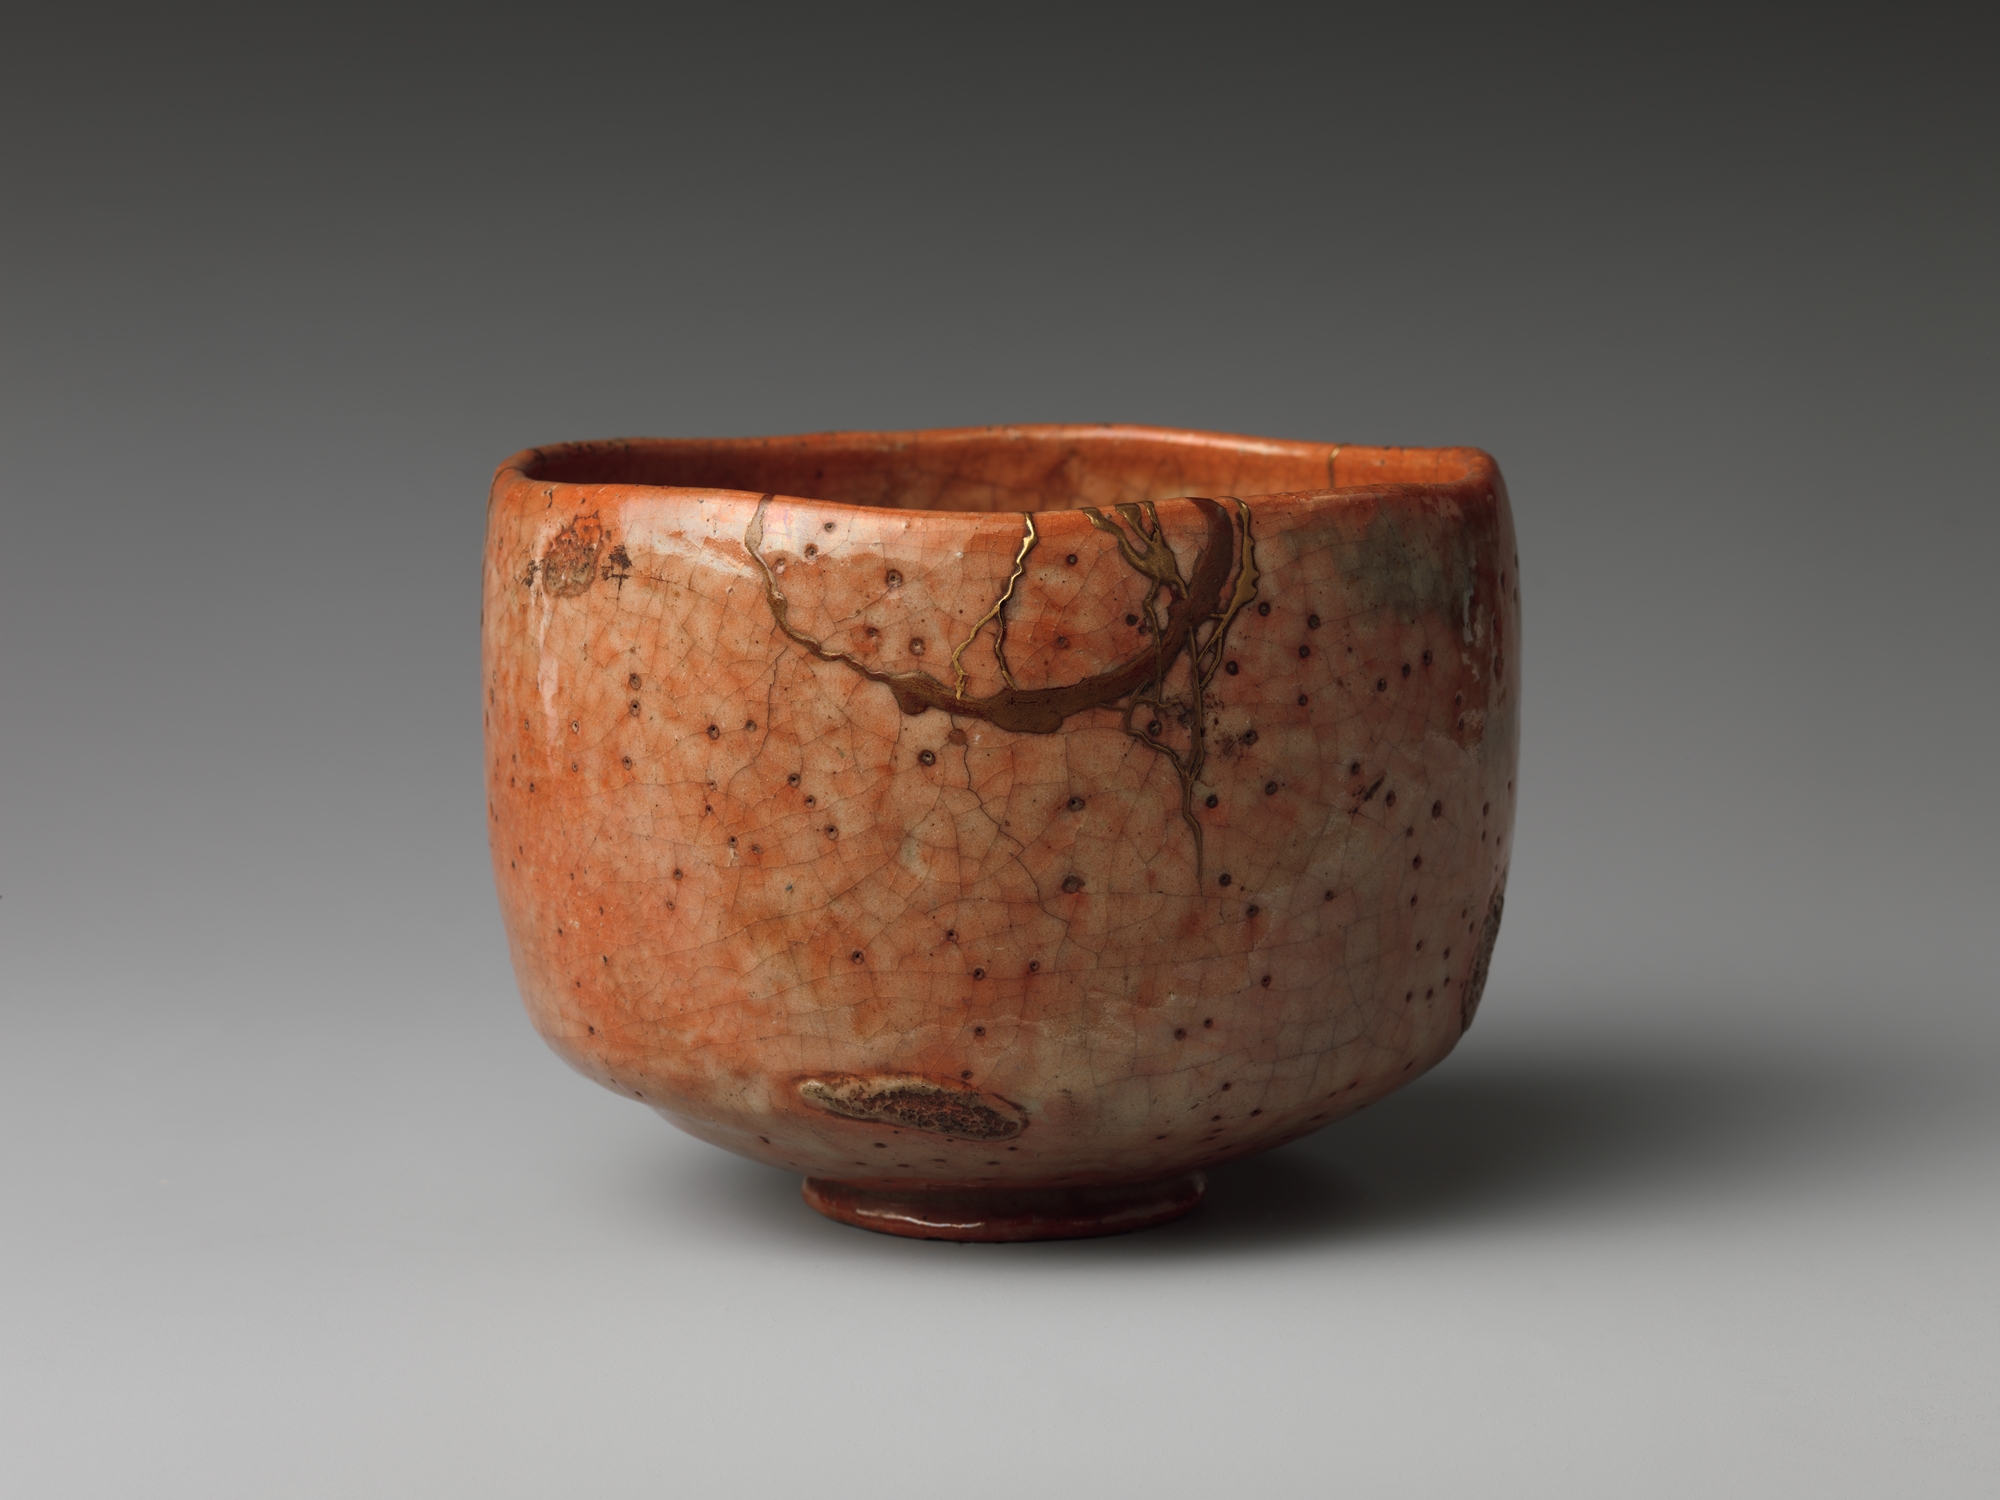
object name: teabowl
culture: japanese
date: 1750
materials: clay, glaze